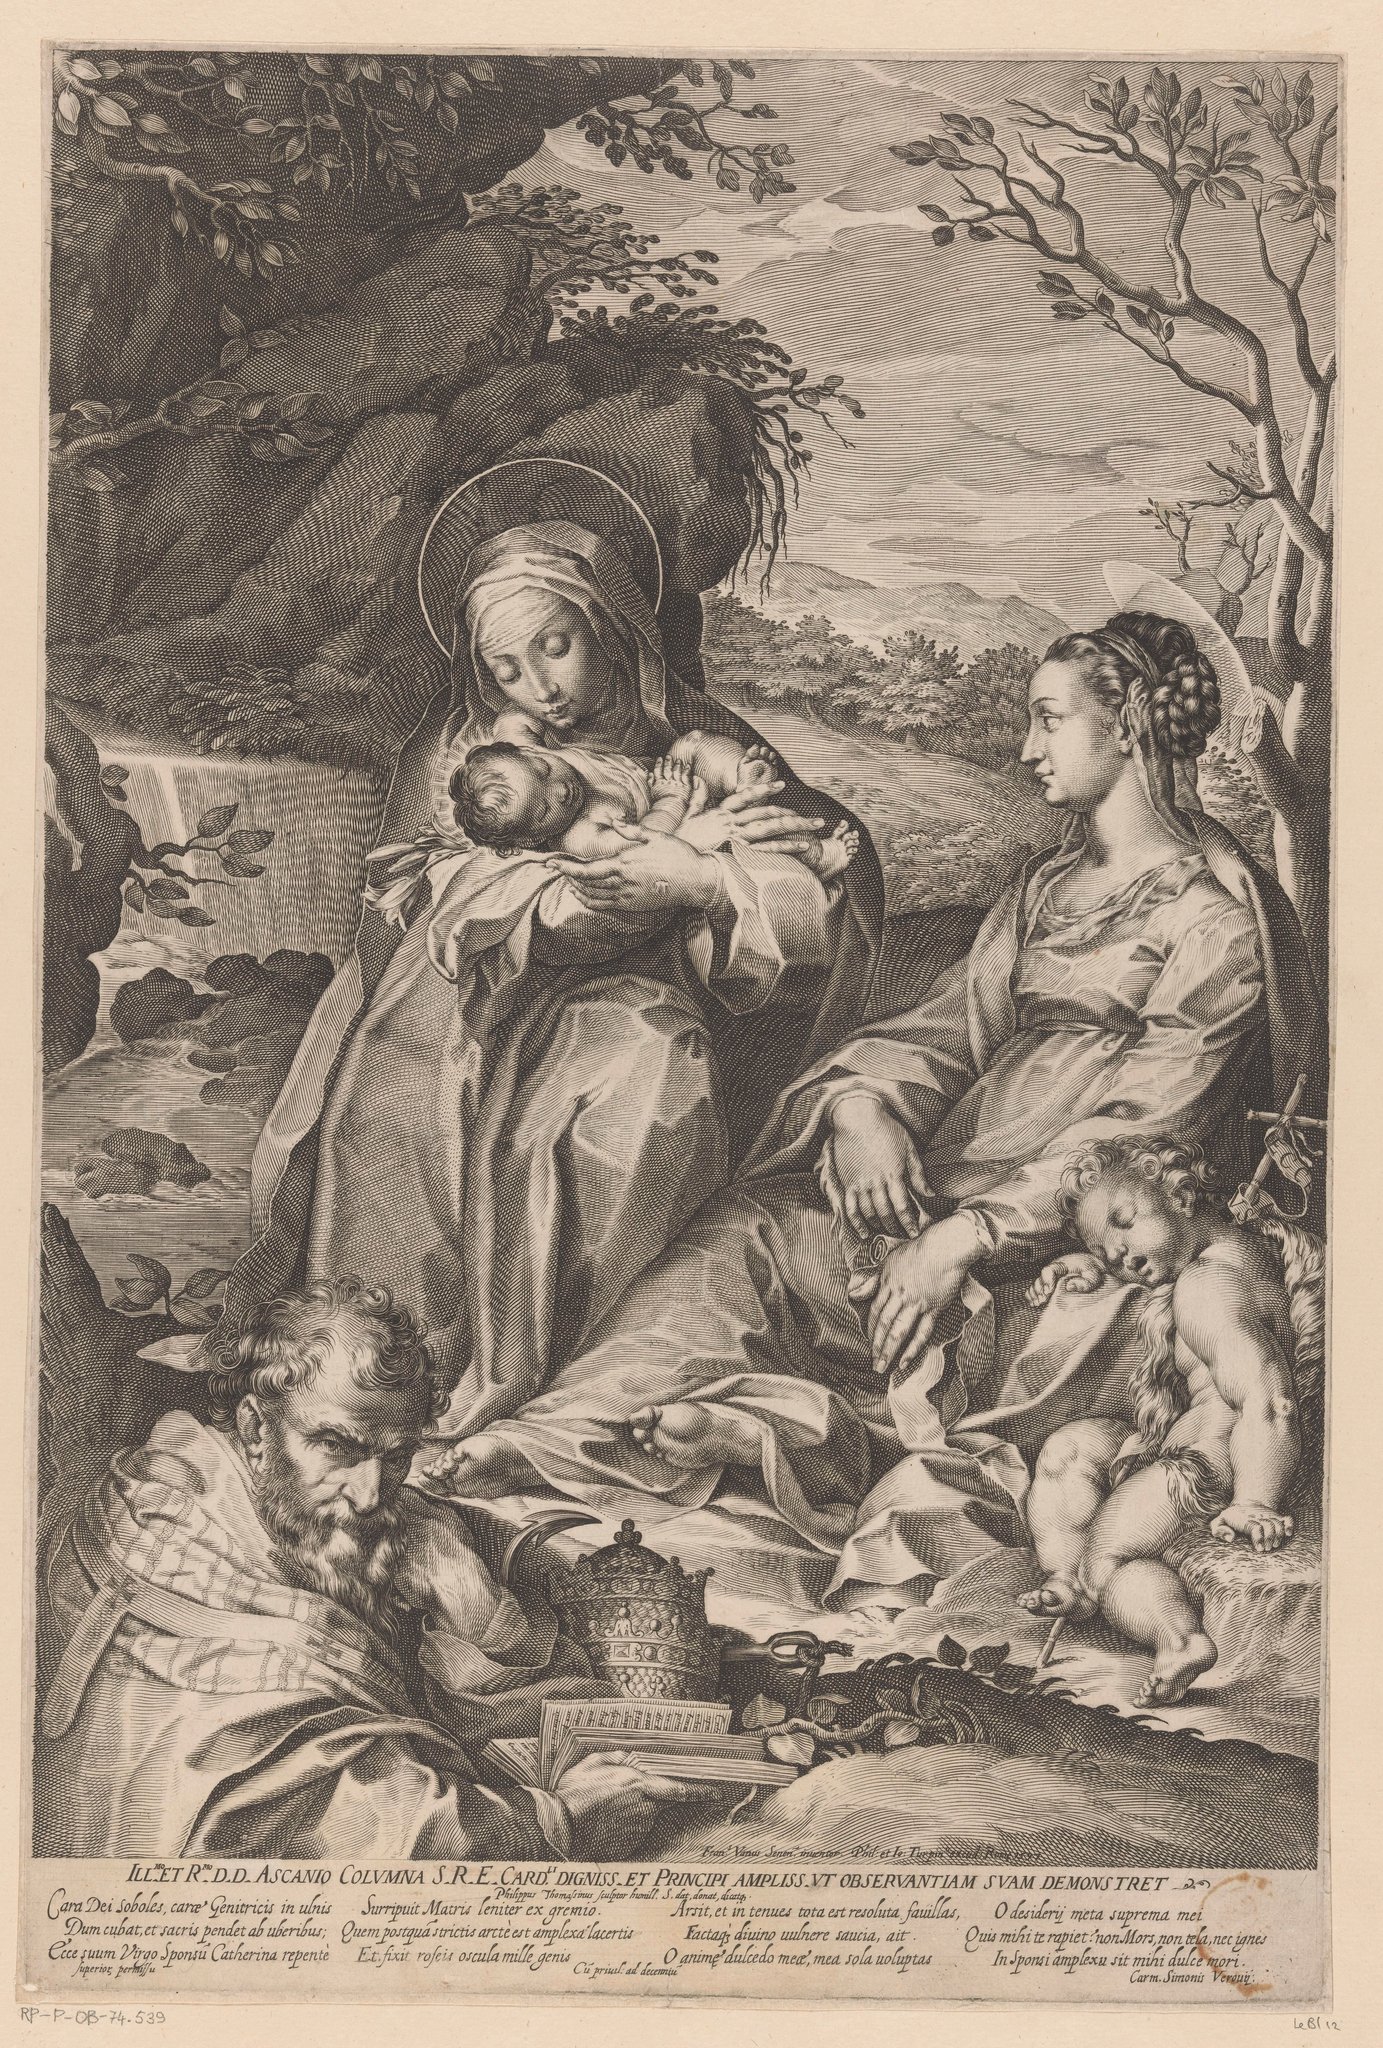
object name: print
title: Heilige Catharina van Siena met het Christuskind, Maria, een slapende Johannes de Doper en een paus Clemens I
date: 1597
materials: paper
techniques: engraving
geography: rome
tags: mary and the christ-child with john the baptist (as child), the virgin and dominican tertiary, catherine of siena; possible attributes: book, cross, crown of thorns, crucifix, demon under foot, heart (with cross), lily, plague-stricken, ring, rosary, stigmata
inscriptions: collector's mark: Lugt 240